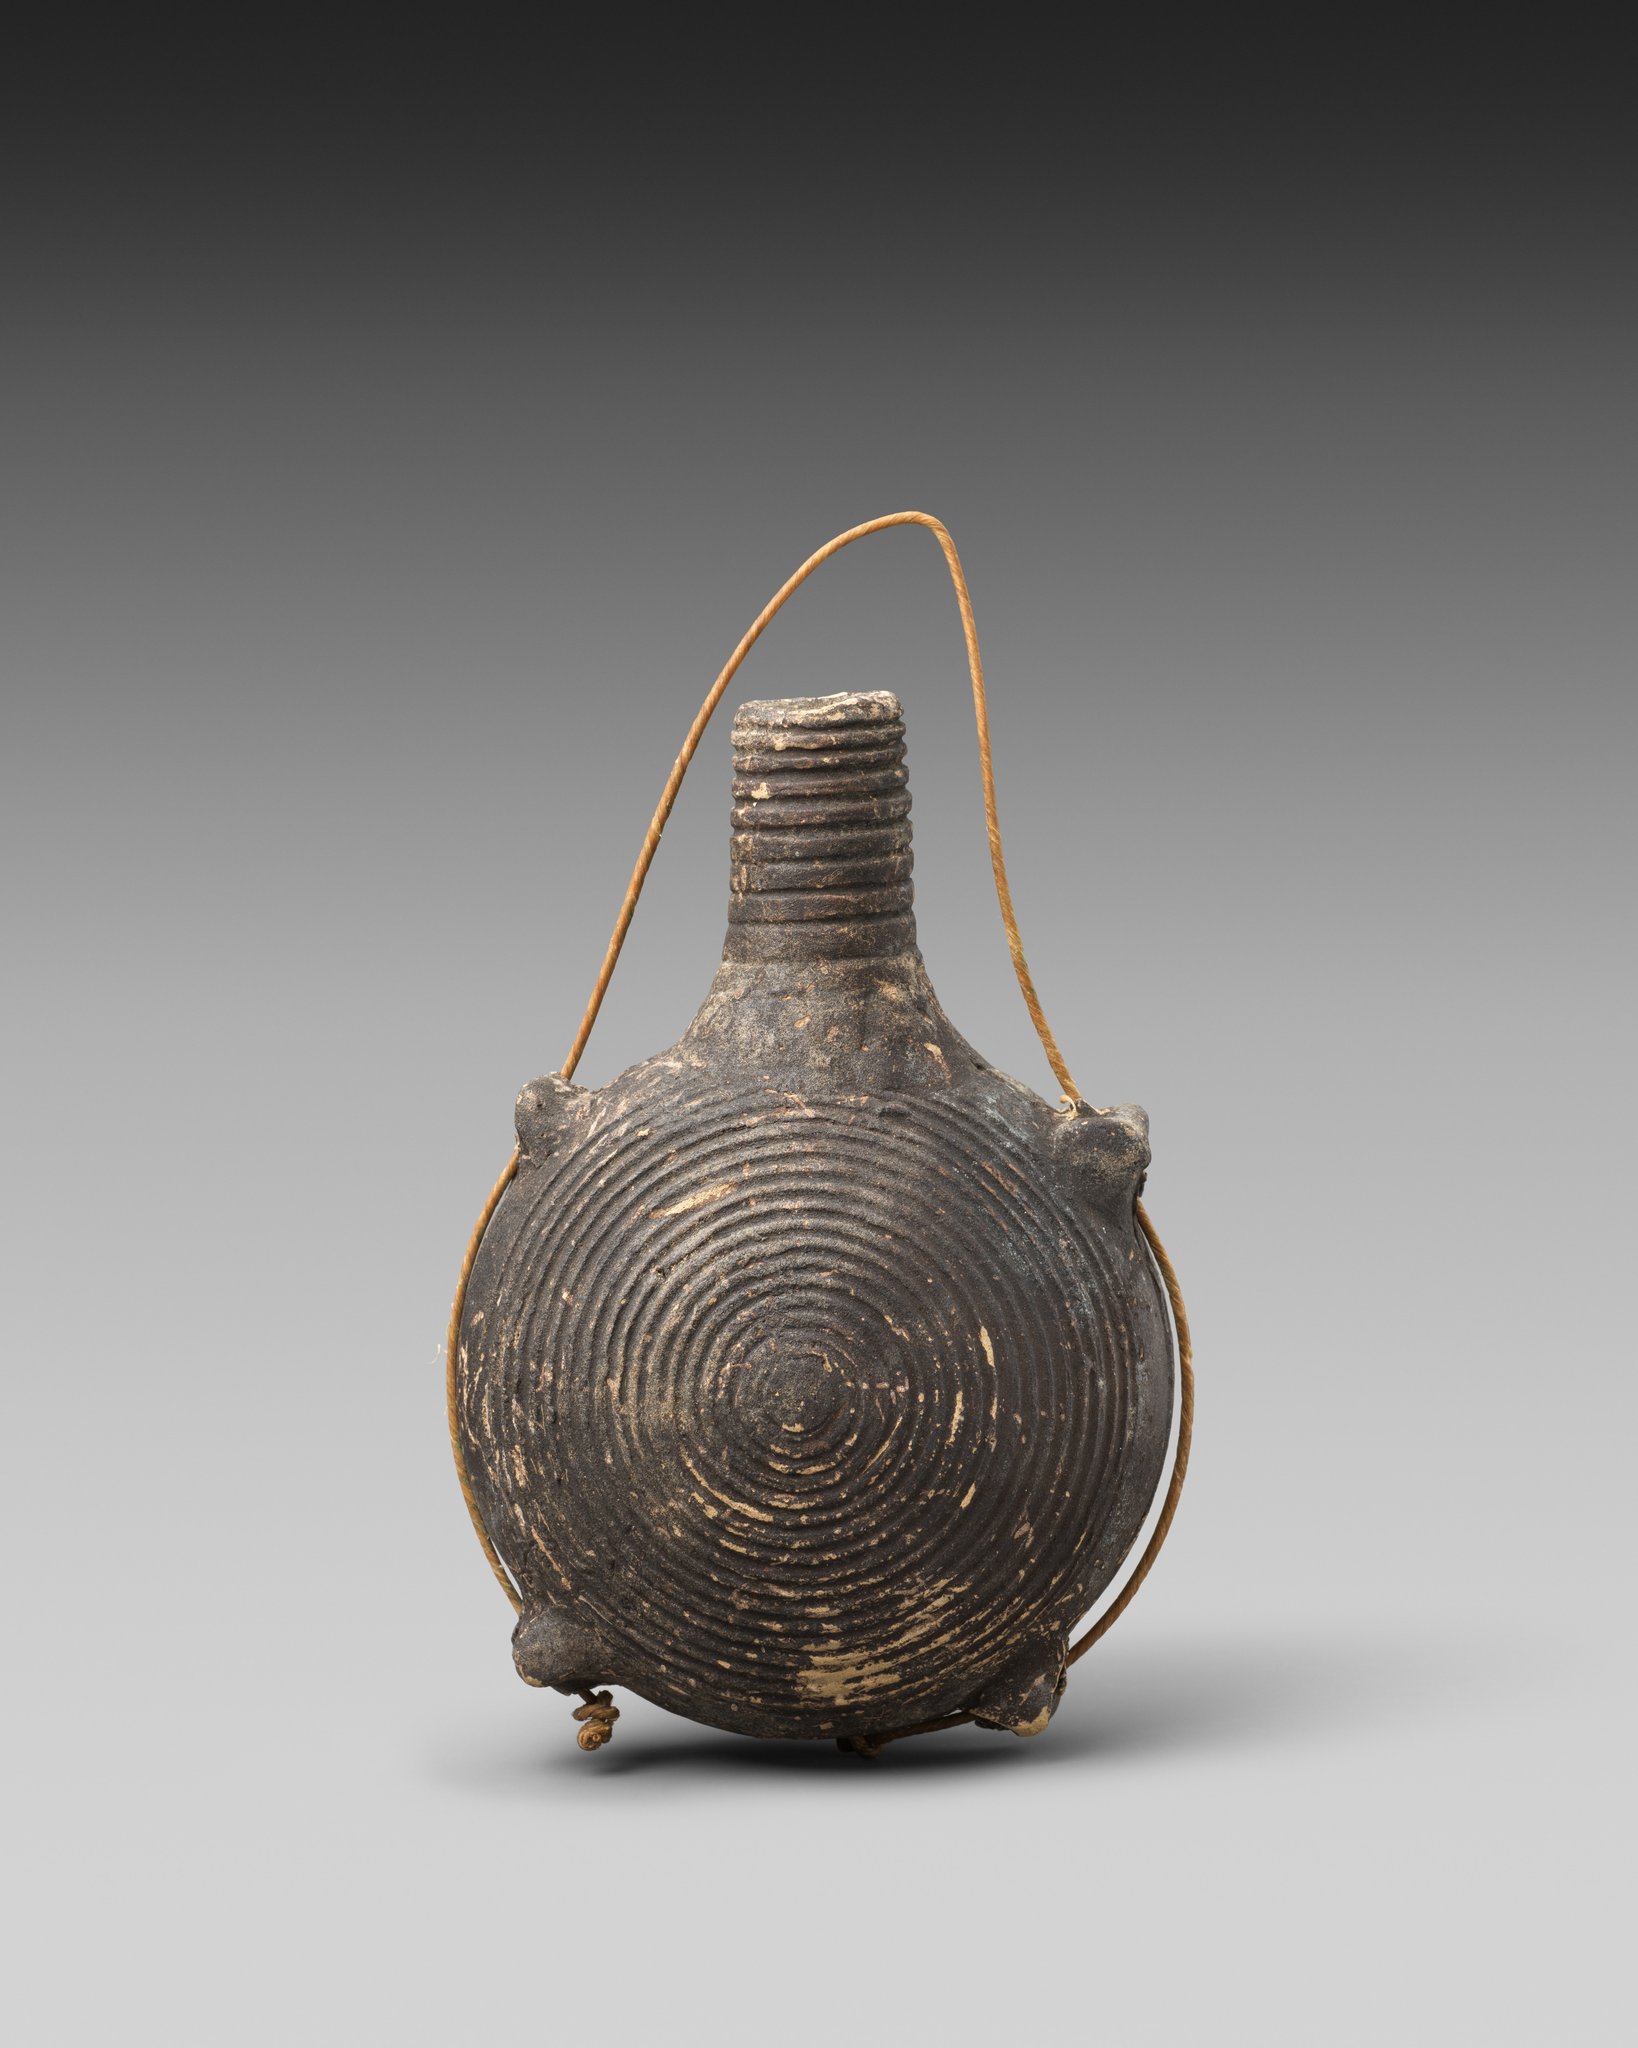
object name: pilgrim flask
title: Terracotta pilgrim flask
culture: cypriot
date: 734-601 BCE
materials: terracotta